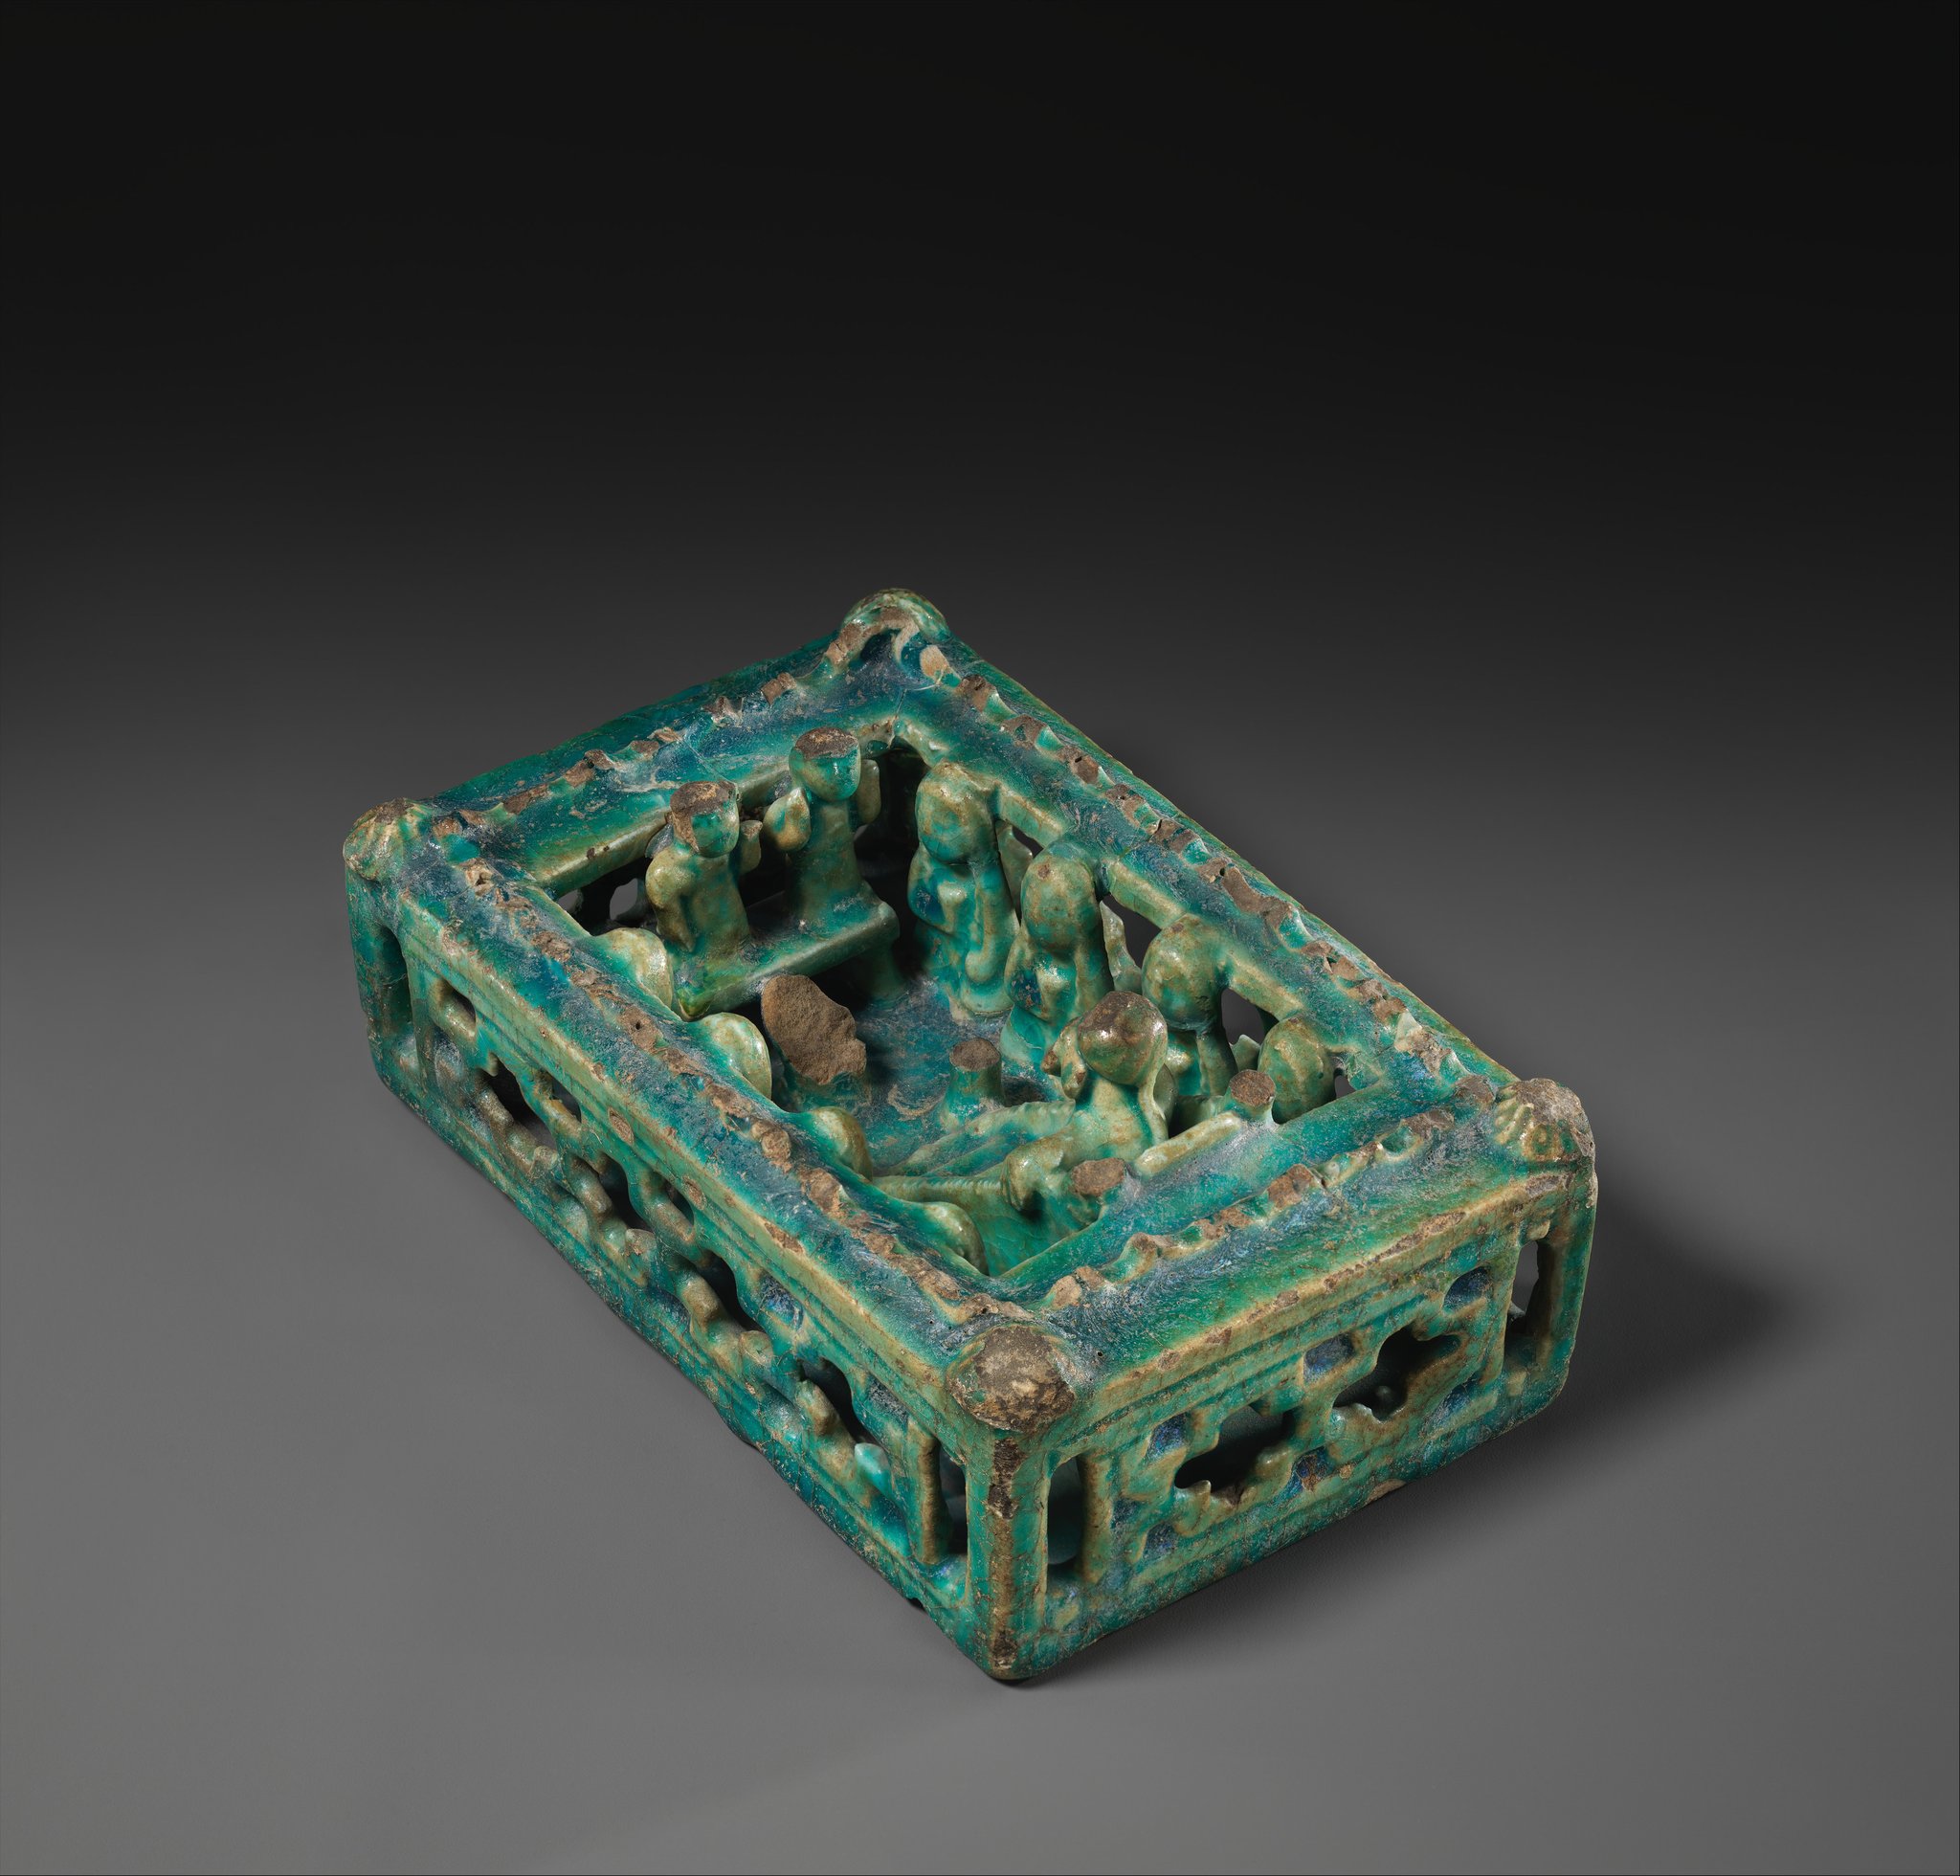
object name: house model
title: Model of a House with Festive Scene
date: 1101-1233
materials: stonepaste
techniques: glazing, molding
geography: iran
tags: houses,courtyards